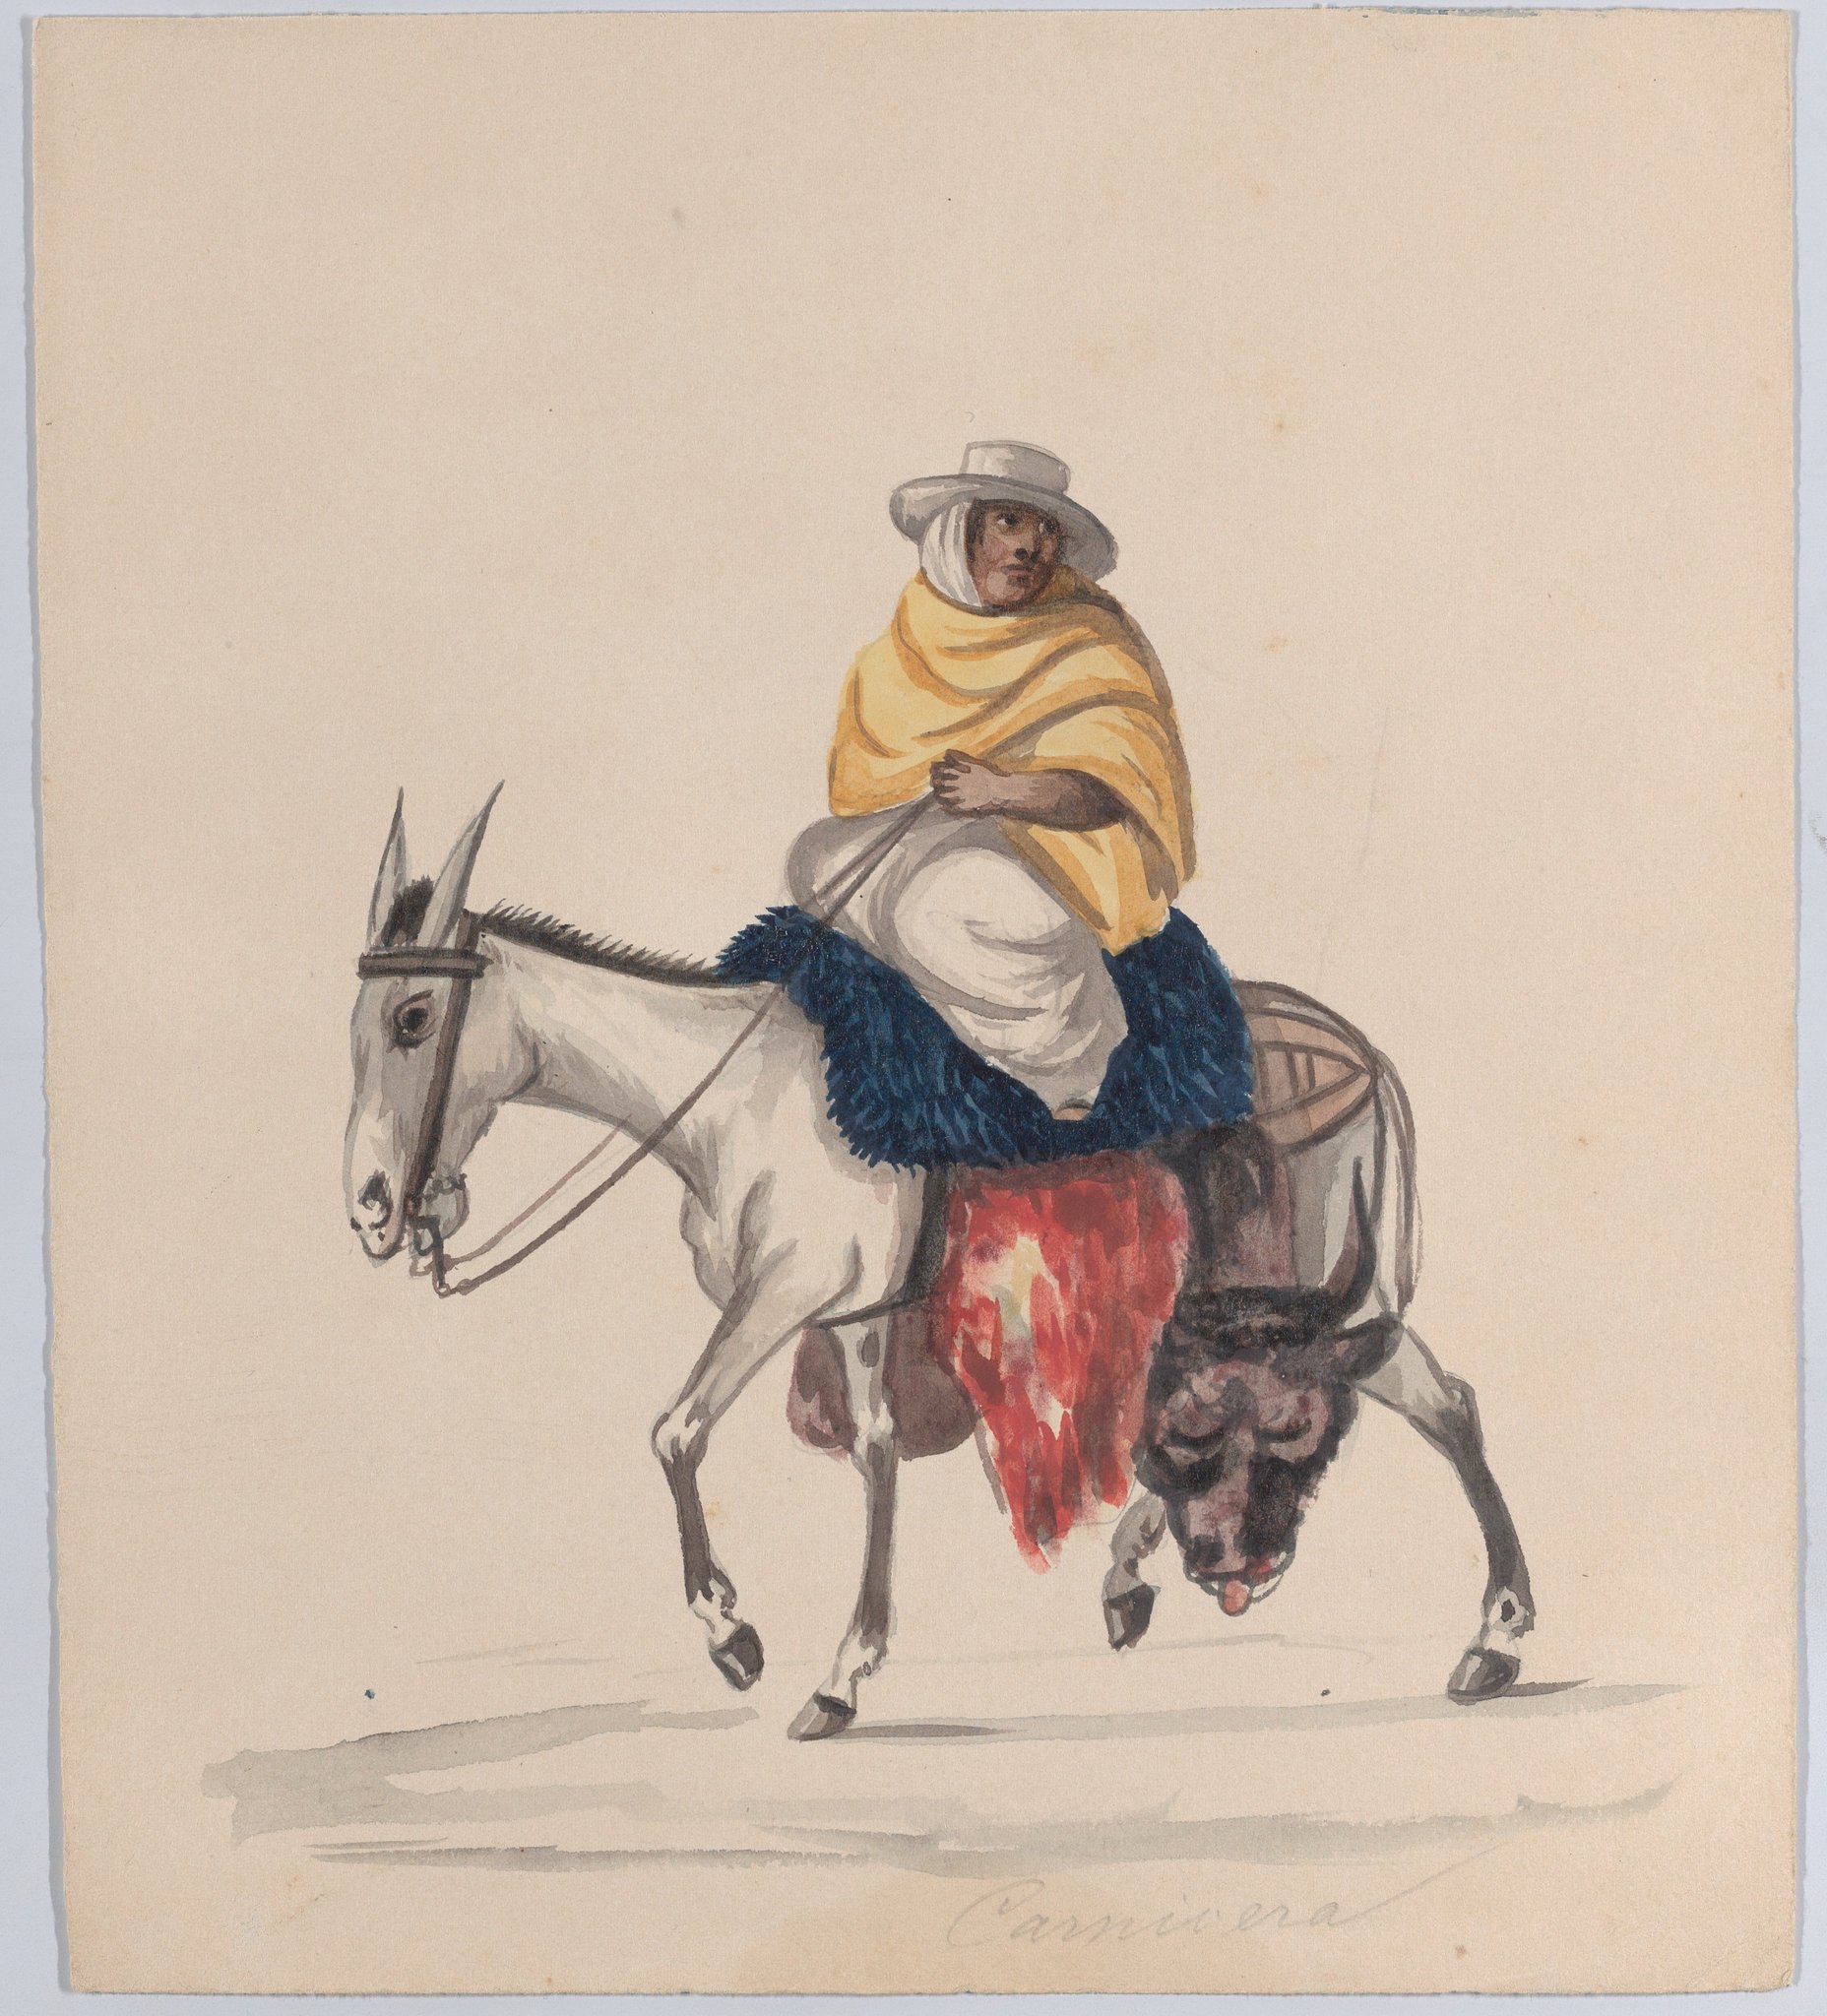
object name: drawing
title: A butcher riding a donkey, from a group of drawings depicting Peruvian dress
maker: francisco (pancho) fierro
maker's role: artist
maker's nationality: african peruvian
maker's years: 1807-1879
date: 1848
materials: watercolor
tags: men,women